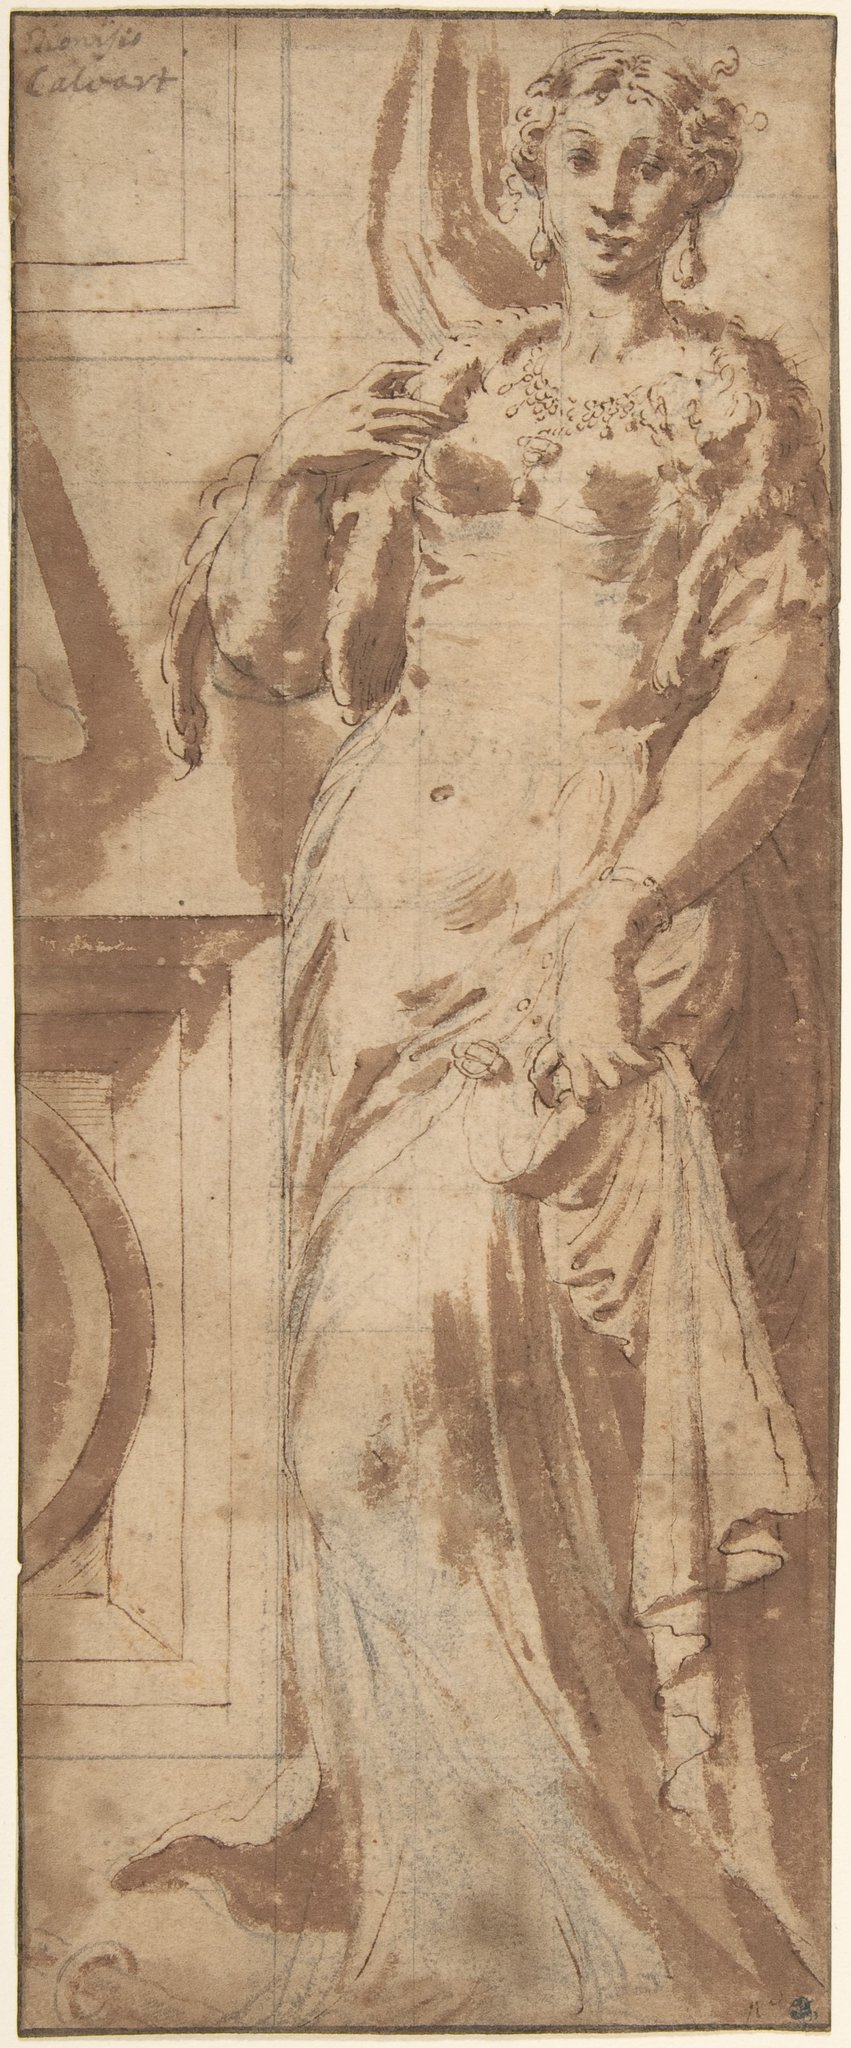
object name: drawing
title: Standing Female Figure and Ornamental Framework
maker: girolamo mazzola bedoli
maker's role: artist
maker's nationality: italian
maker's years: 1505-1570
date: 1547-1553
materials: chalk, ink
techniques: brush, pen, drawing, wash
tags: female nudes